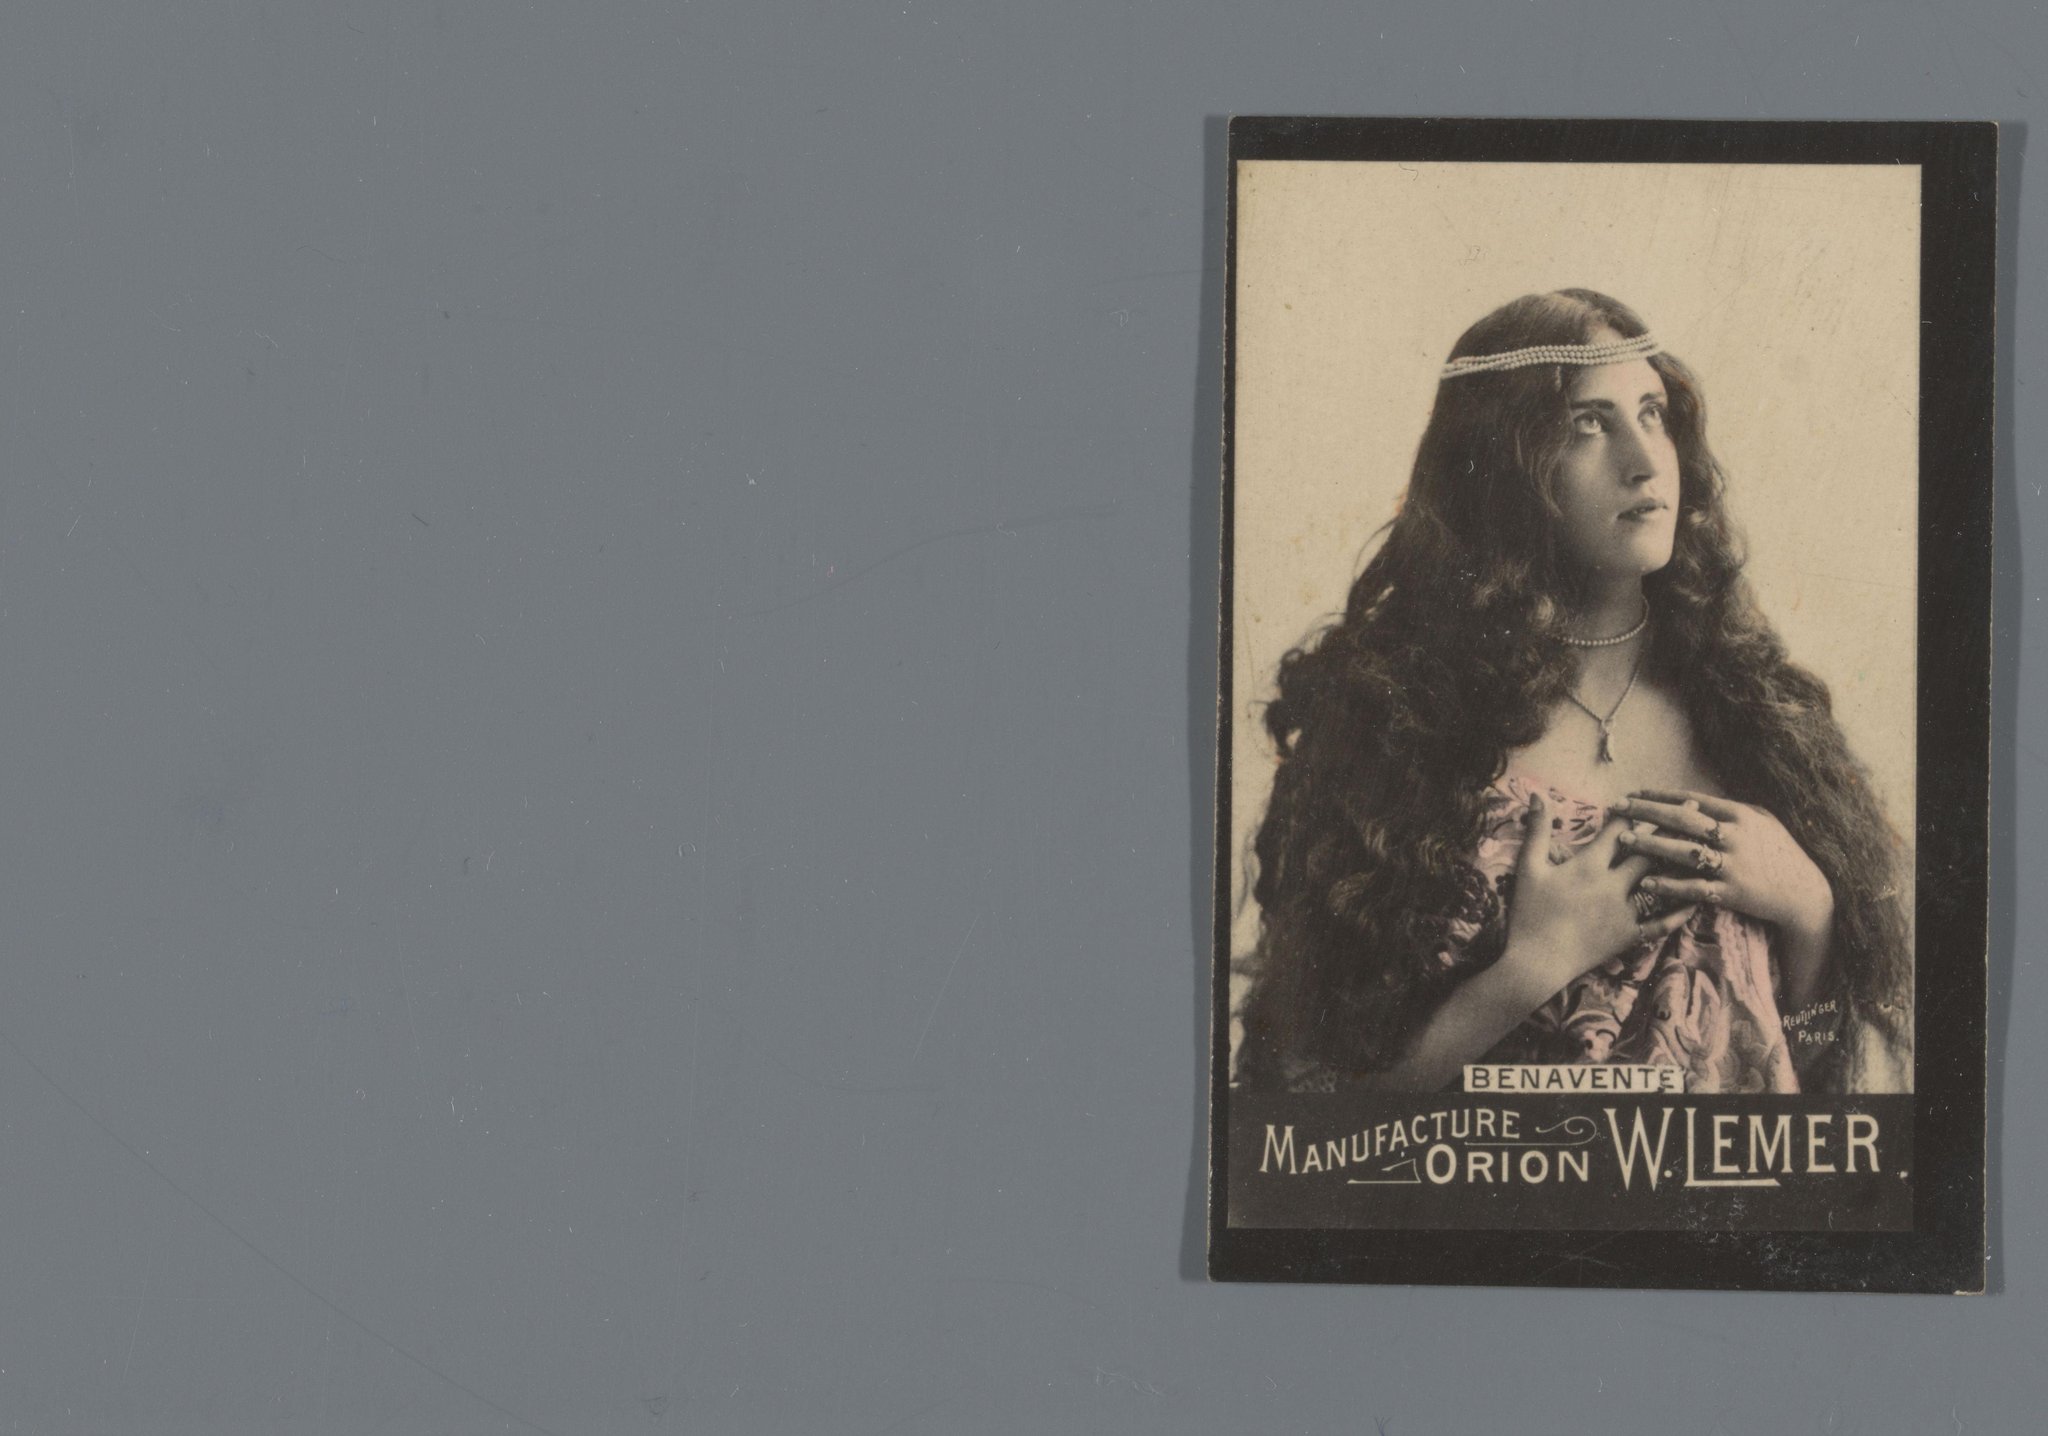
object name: photograph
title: Benavente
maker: léopold reutlinger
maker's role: fotograaf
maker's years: 1863-1937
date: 1890-1900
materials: photographic support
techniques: gelatin silver print, hand coloring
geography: paris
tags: historical persons - bb - woman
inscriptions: inscription: ‘MANUFACTURE/ ORION W. LEMER.’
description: Dergelijke foto's stonden bekend als 'zwartjes'. Men verkreeg ze bij aanschaf van bepaalde merken thee, cacao, sigaretten, beschuit, etc. om te verzamelen. Er waren speciaal voor de 'zwartjes' vervaardigde verzamelalbums in omloop.